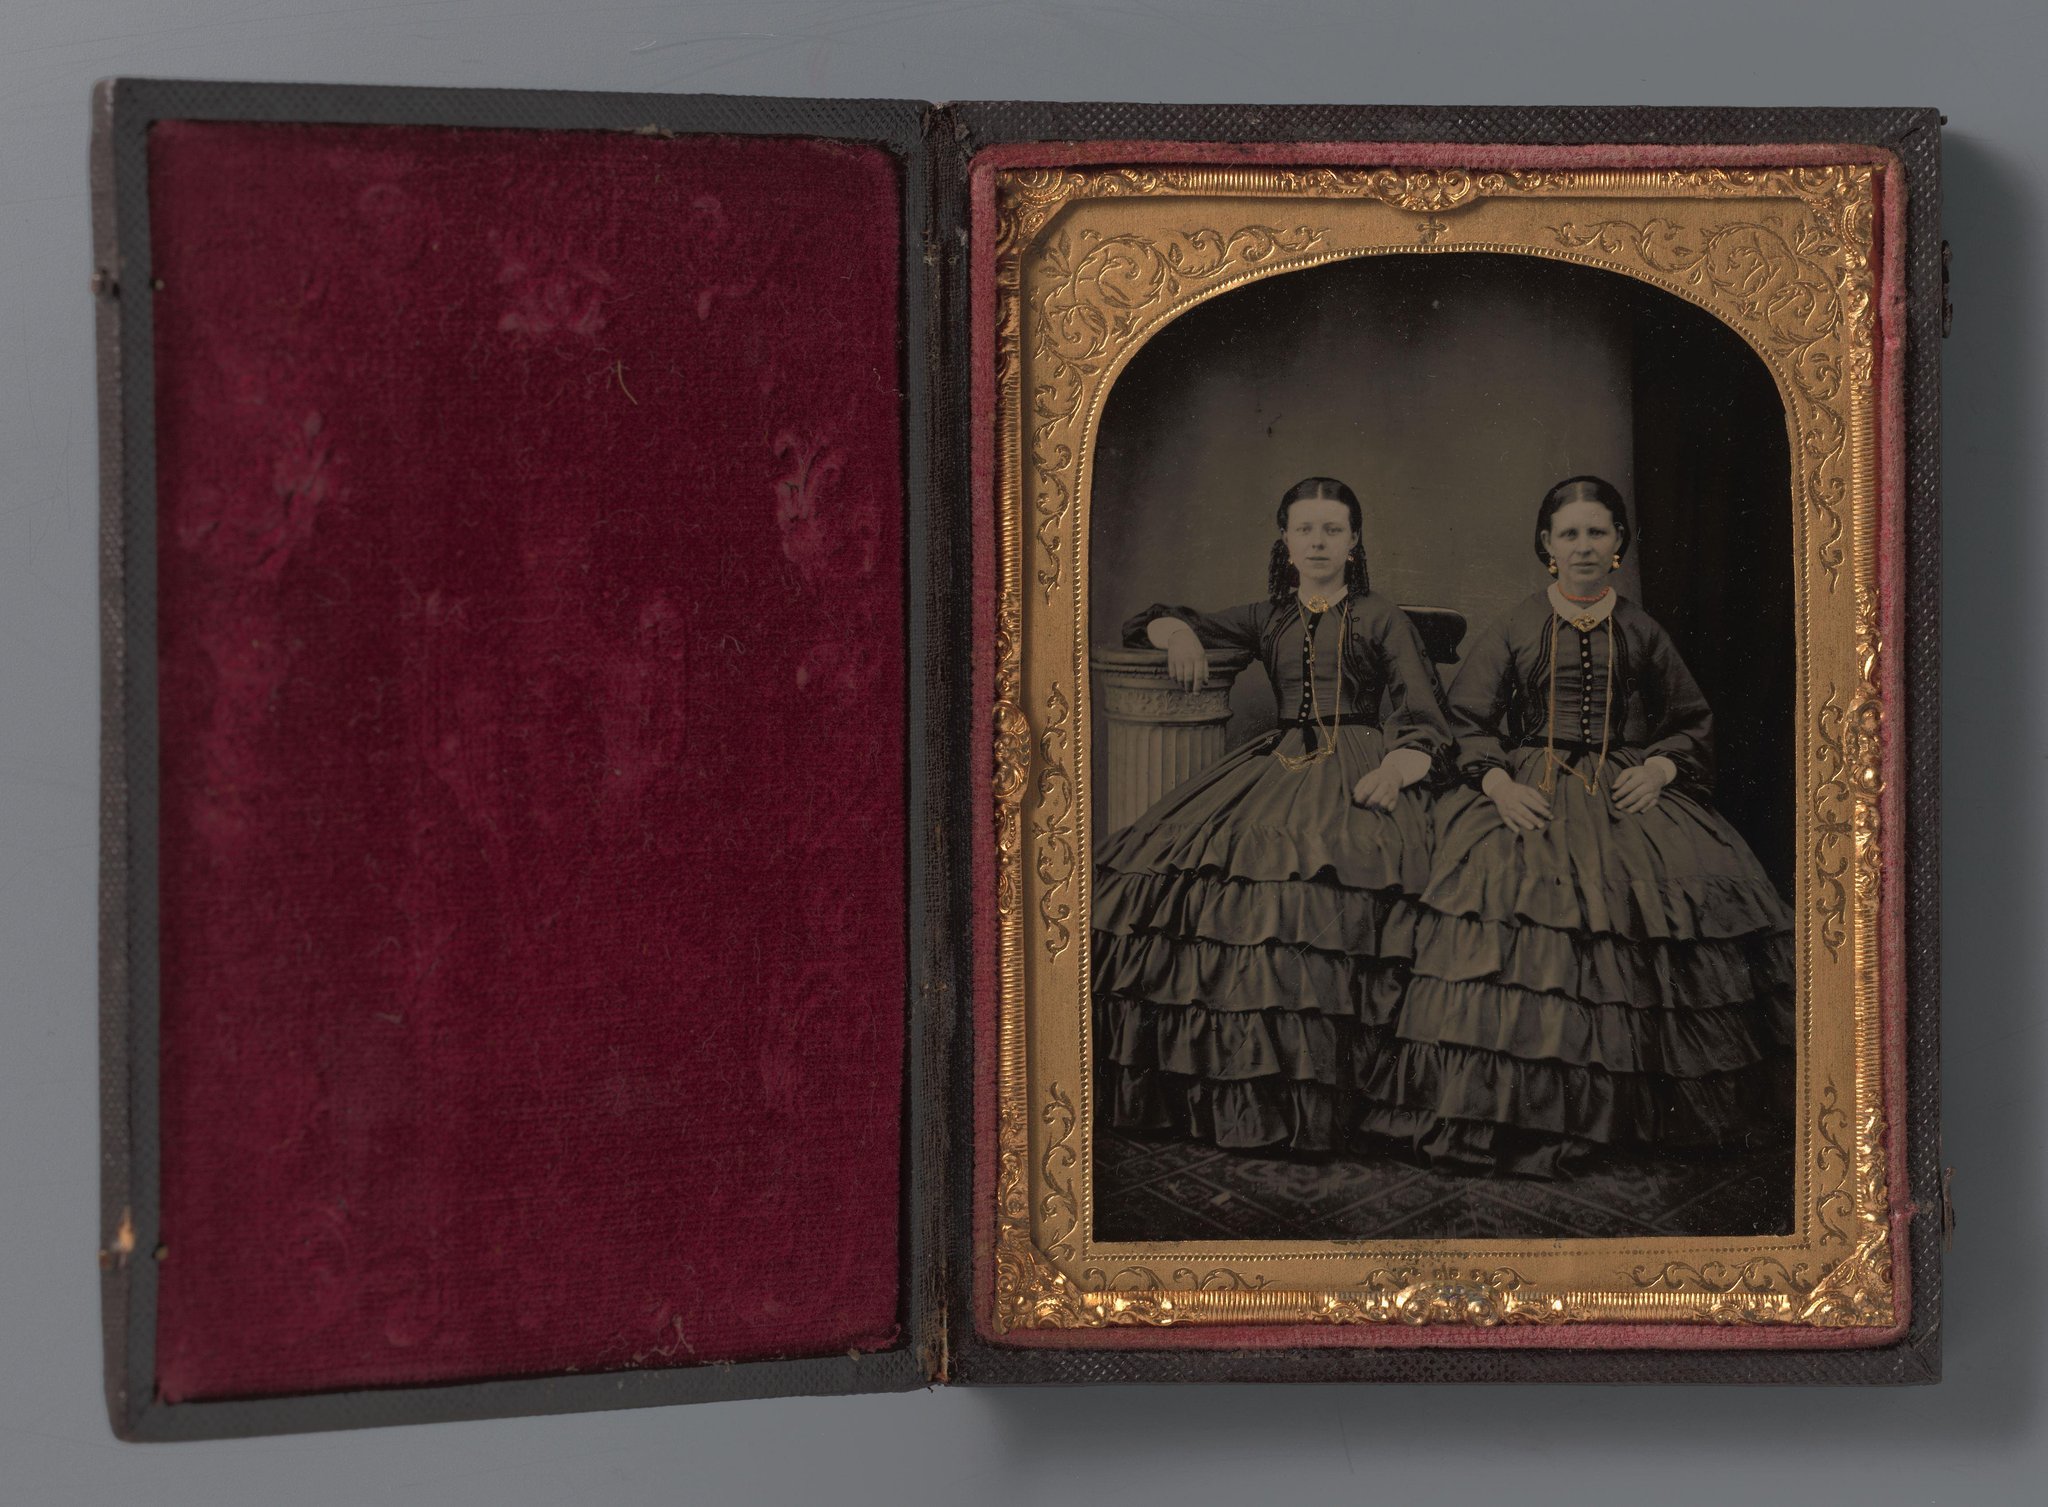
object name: photograph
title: Portret van twee onbekende jonge vrouwen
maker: Anonymous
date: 1855-1870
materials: glass, metal, paper, velvet, wood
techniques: ambrotype, hand coloring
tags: sitting figure - aa - female human figure, historical persons - bb - woman, adolescent, young woman, maiden (+ two persons)